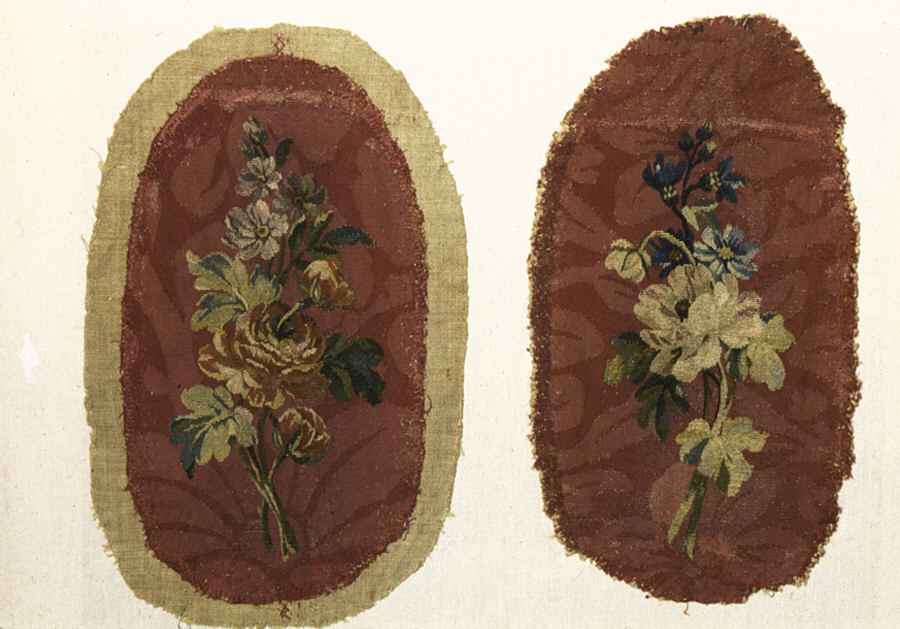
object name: upholstery panel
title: Armrests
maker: manufacture nationale des gobelins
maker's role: manufactory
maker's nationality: french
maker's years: 1662-1799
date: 1766-1771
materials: silk, wool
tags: flowers